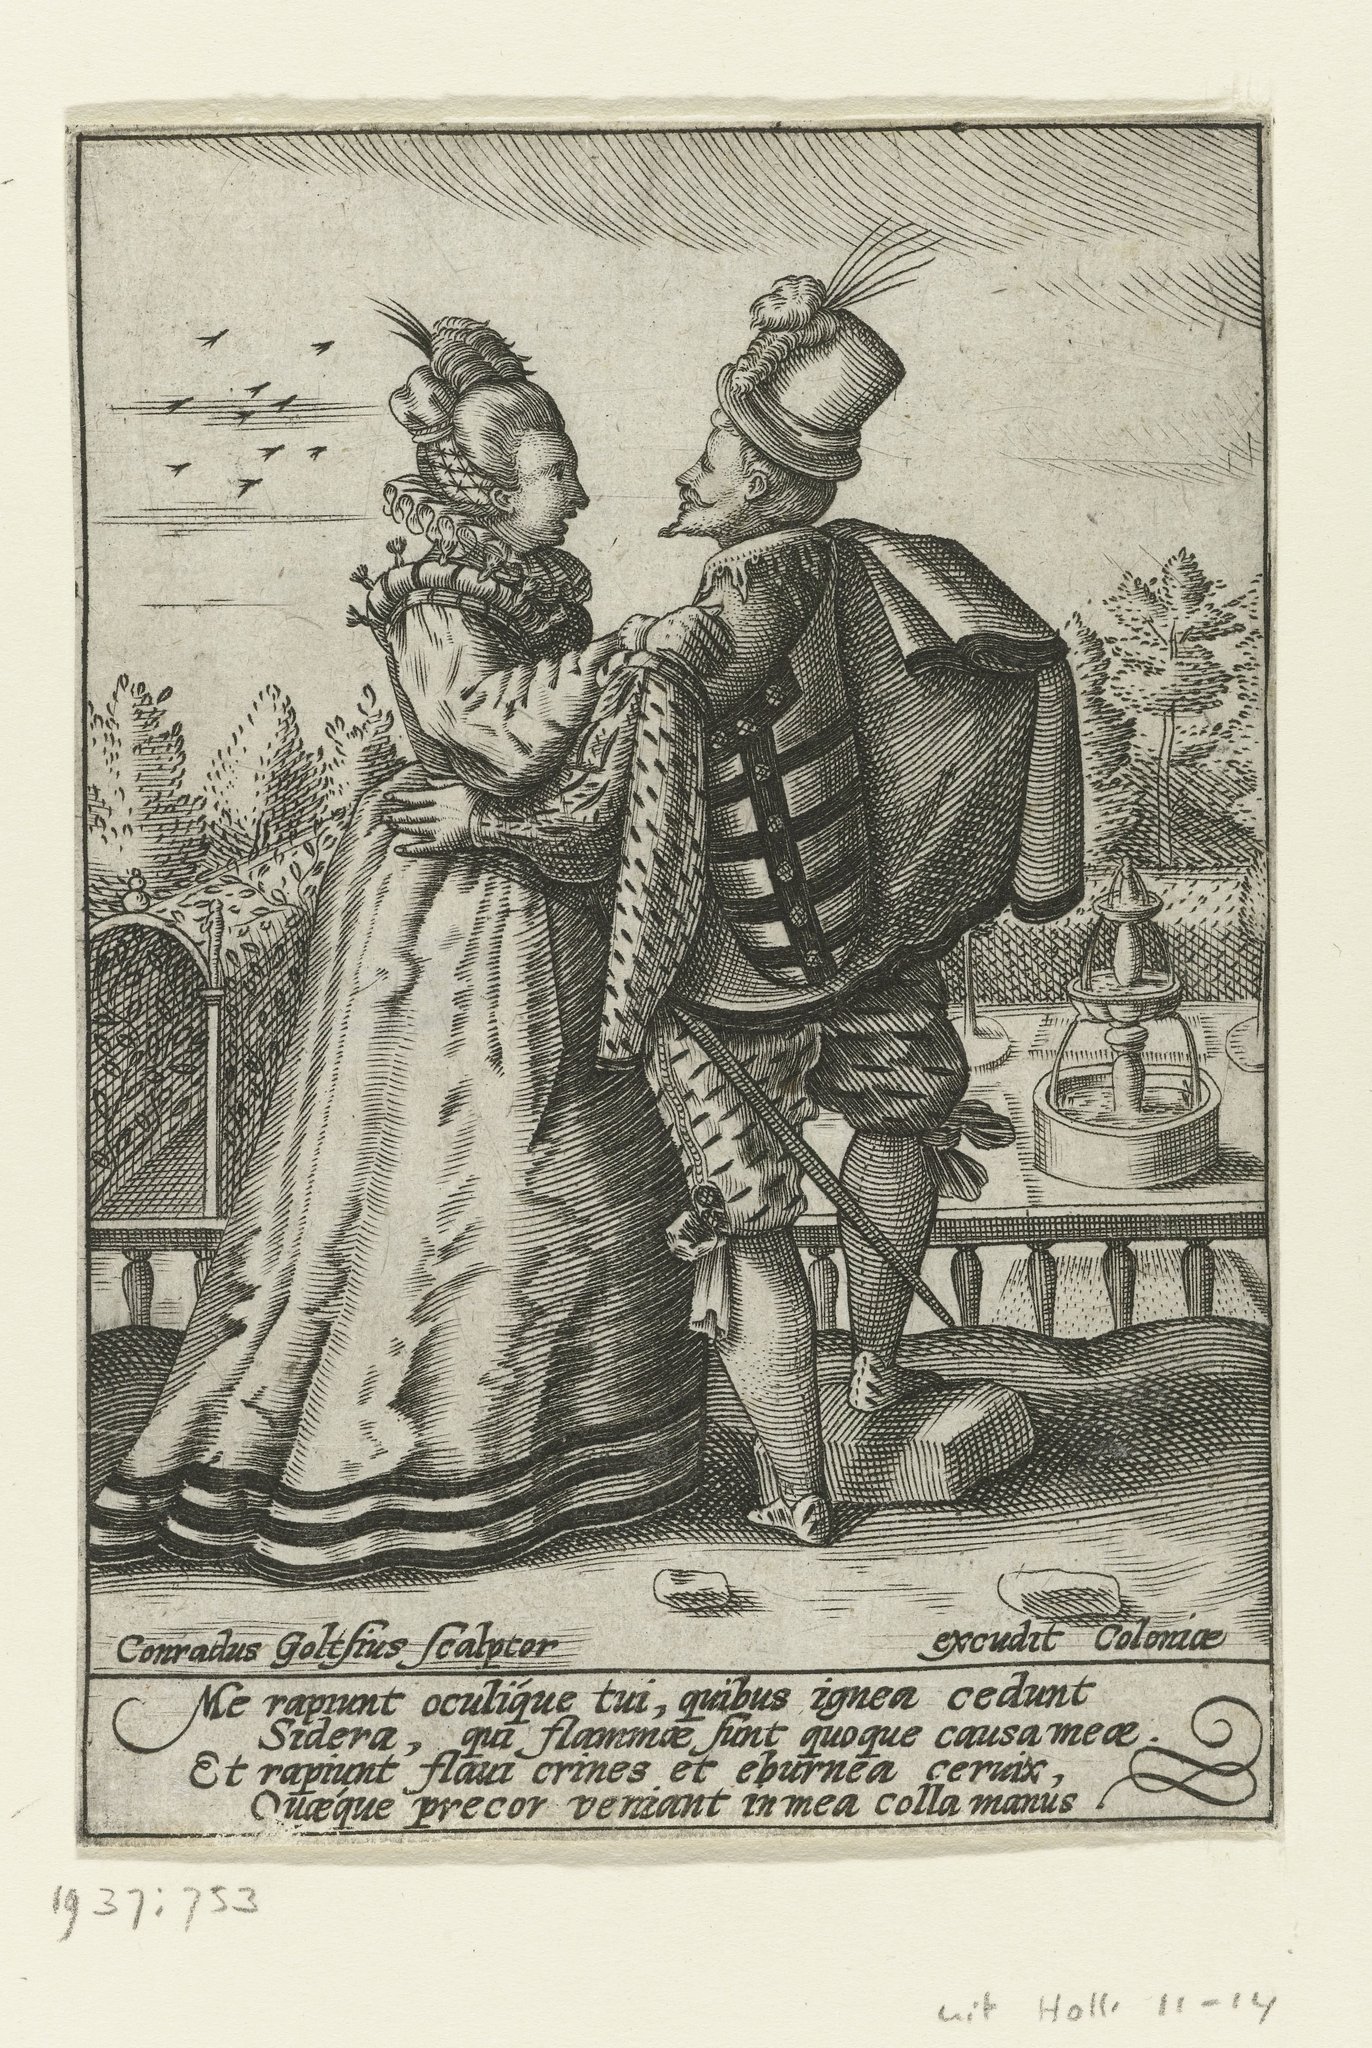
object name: print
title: Amantum aliquot paria adiumbrata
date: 1595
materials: paper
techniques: engraving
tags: cape (+ men's clothes), head-gear: hat (+ men's clothes), clothes, costume (+ women's clothes), head-gear: hat (+ women's clothes), dress, gown (+ women's clothes), clothes, costume (+ men's clothes), trousers, breeches, etc. (breeches) (+ men's clothes), couple of lovers, sleeves (+ men's clothes)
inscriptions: collector's mark: Lugt 2228, collector's mark: Lugt 2760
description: Beiden zijn gekleed volgens de adellijke mode van ca. 1590-'95. De vrouw draagt een overkleed met ruim vallende mouwen en schouderkleppen* (bragoenen*), een lubbenkraag* en als hoofdbedekking een haarnet* met hoedje. De man draagt een korte mantel* over een wambuis* met loshangende siermouwen*, een kuitbroek* en schoenen met splitten. Een hoge hoed op zijn hoofd.